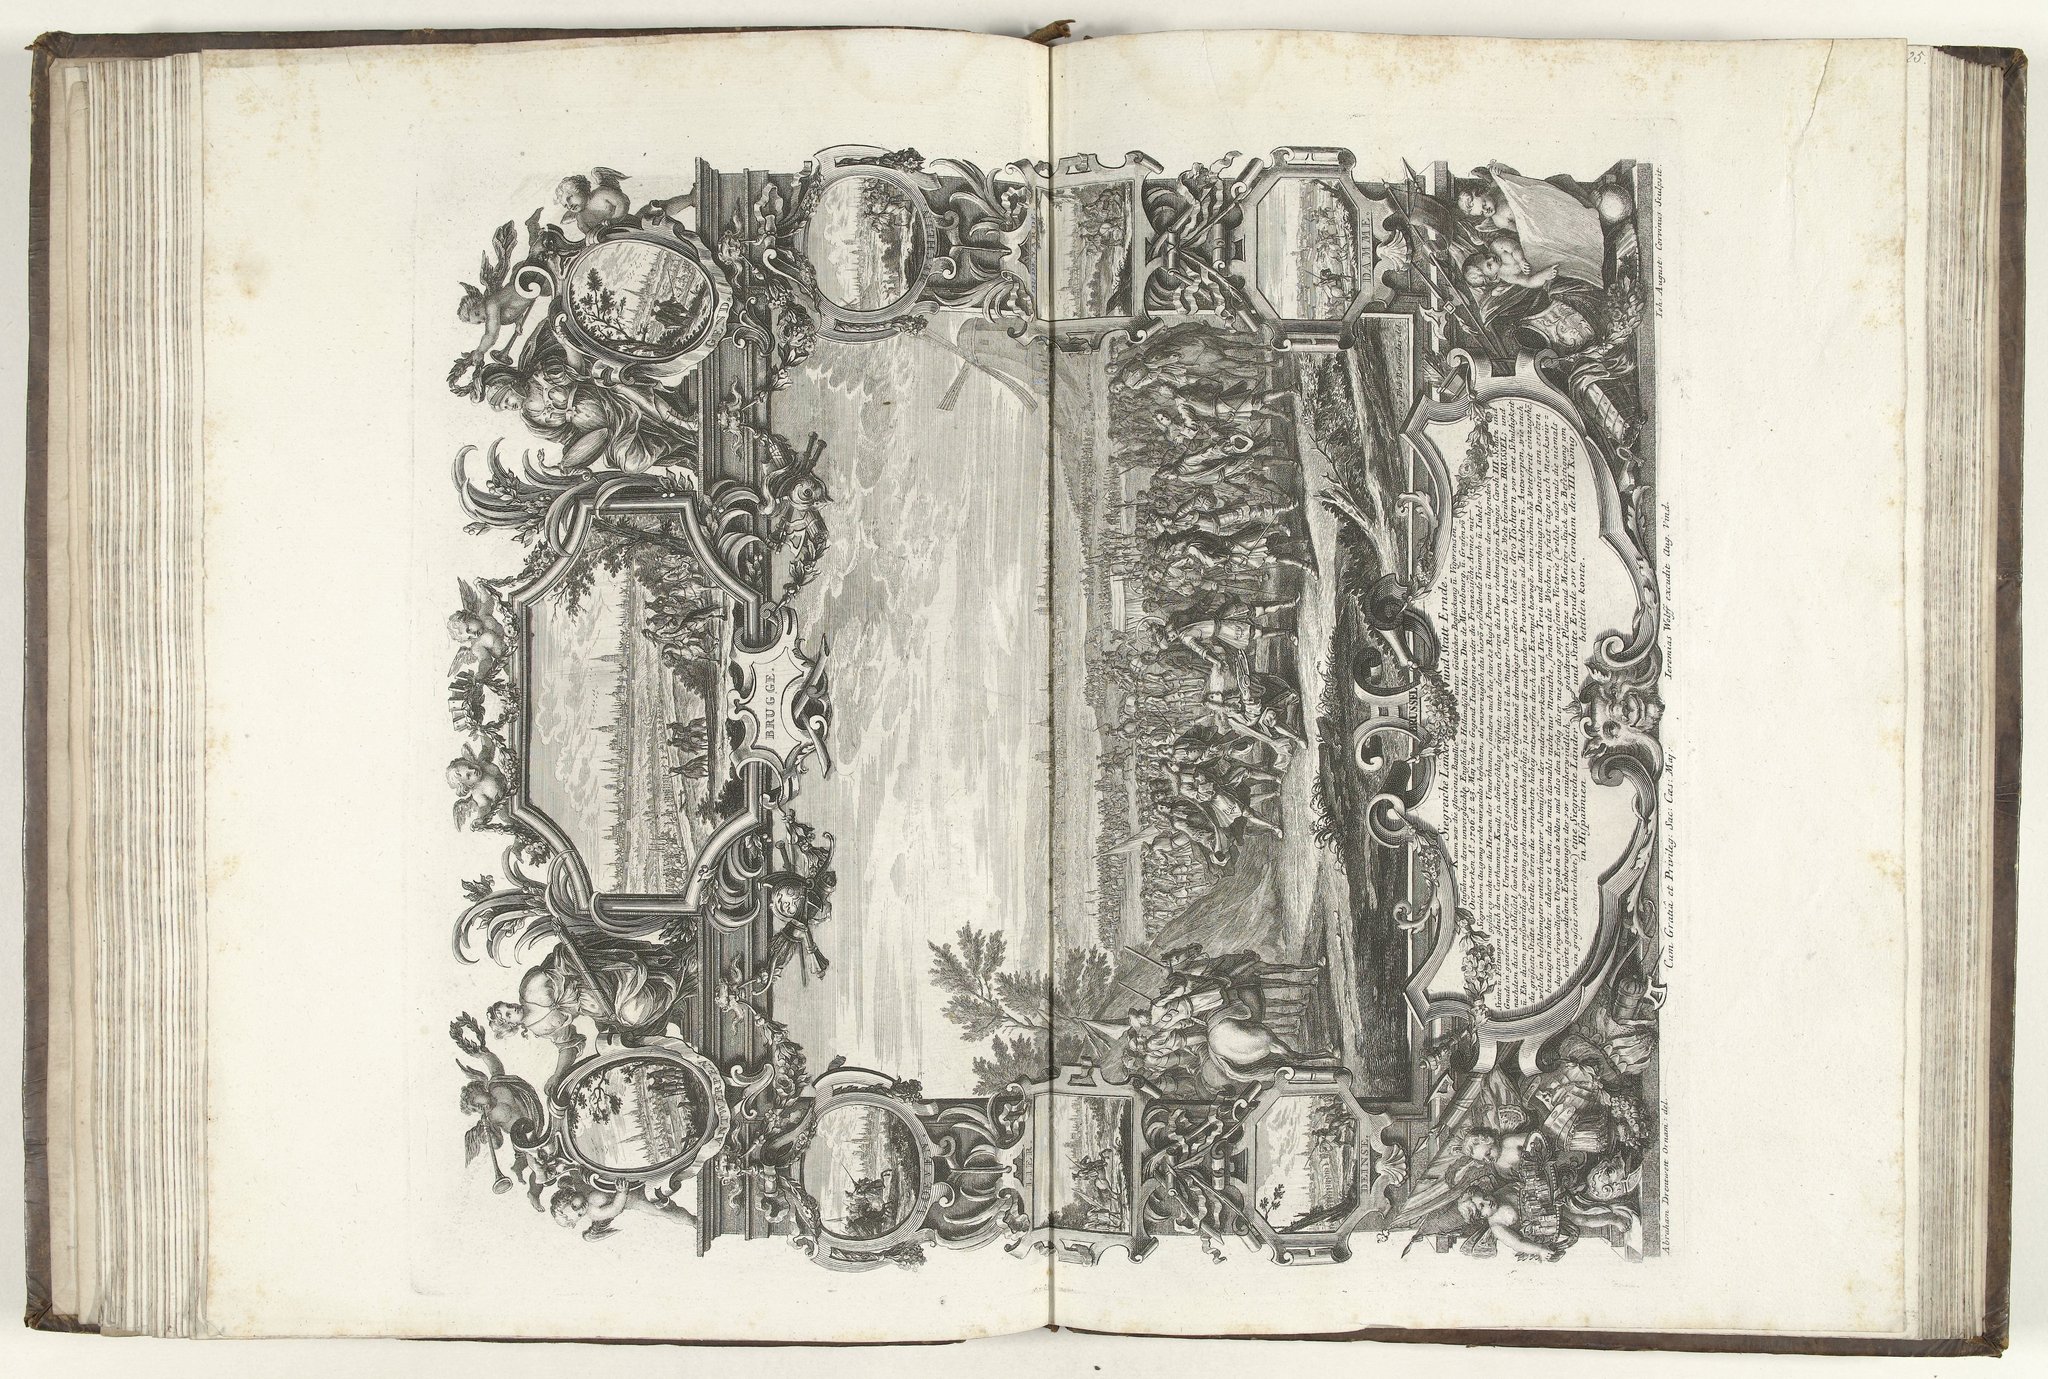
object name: print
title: Overgave van de Vlaamse steden, 1706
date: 1712-1715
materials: paper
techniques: engraving, etching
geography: augsburg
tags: surrender of keys, antwerp, mechelen, ghent, brussels, bruges, louvain, lierre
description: Overgave van tien steden in Vlaanderen en Brabant na de overwinning van de Geallieerden in de slag bij Ramillies. In de centrale voorstelling de overgave van Brussel, in een rijk versierde ornamentele omlijsting met cartouches met de andere negen steden die zich overgaven, bovenaan Brugge. Onderaan een cartouche met de beschrijving van de gebeurtenissen in het Duits. Blad in de gebonden verzameling platen uitgebracht onder de titel: Repraesentatio belli ... Der Spanische Successions-Krieg [ca. 1720].